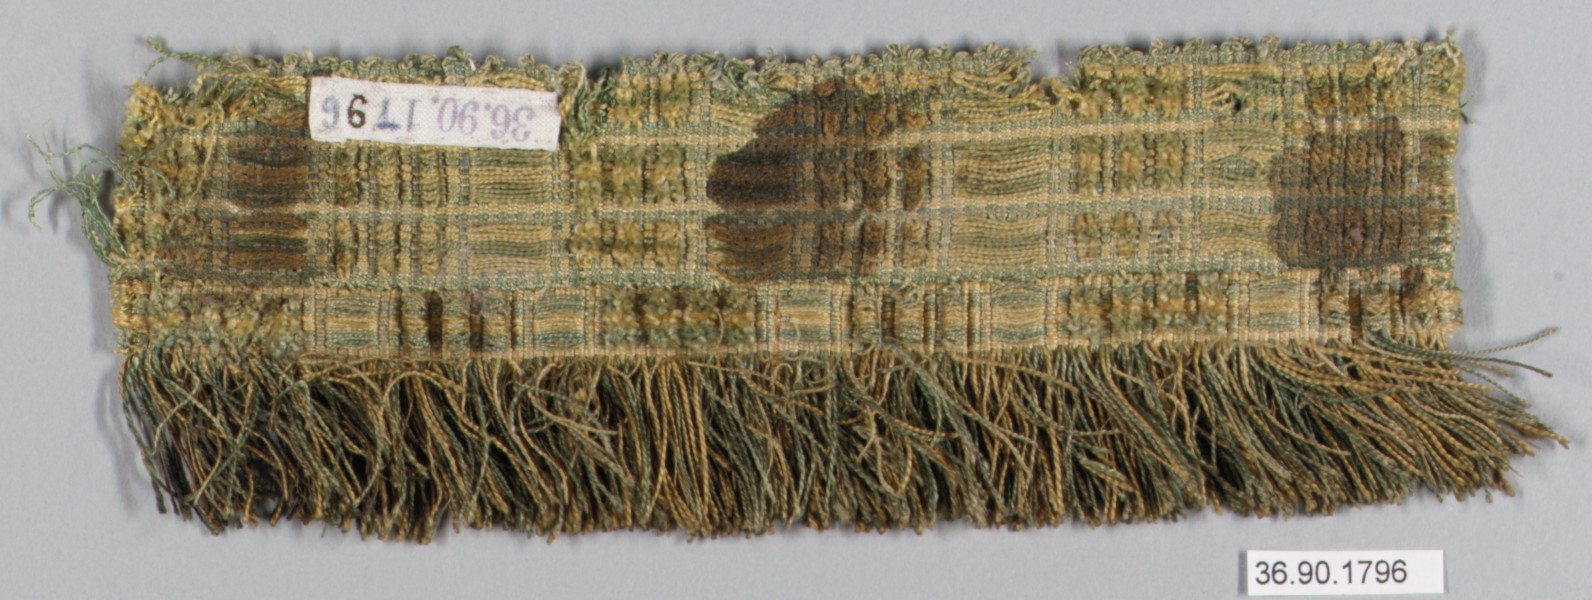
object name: fringe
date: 1770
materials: silk